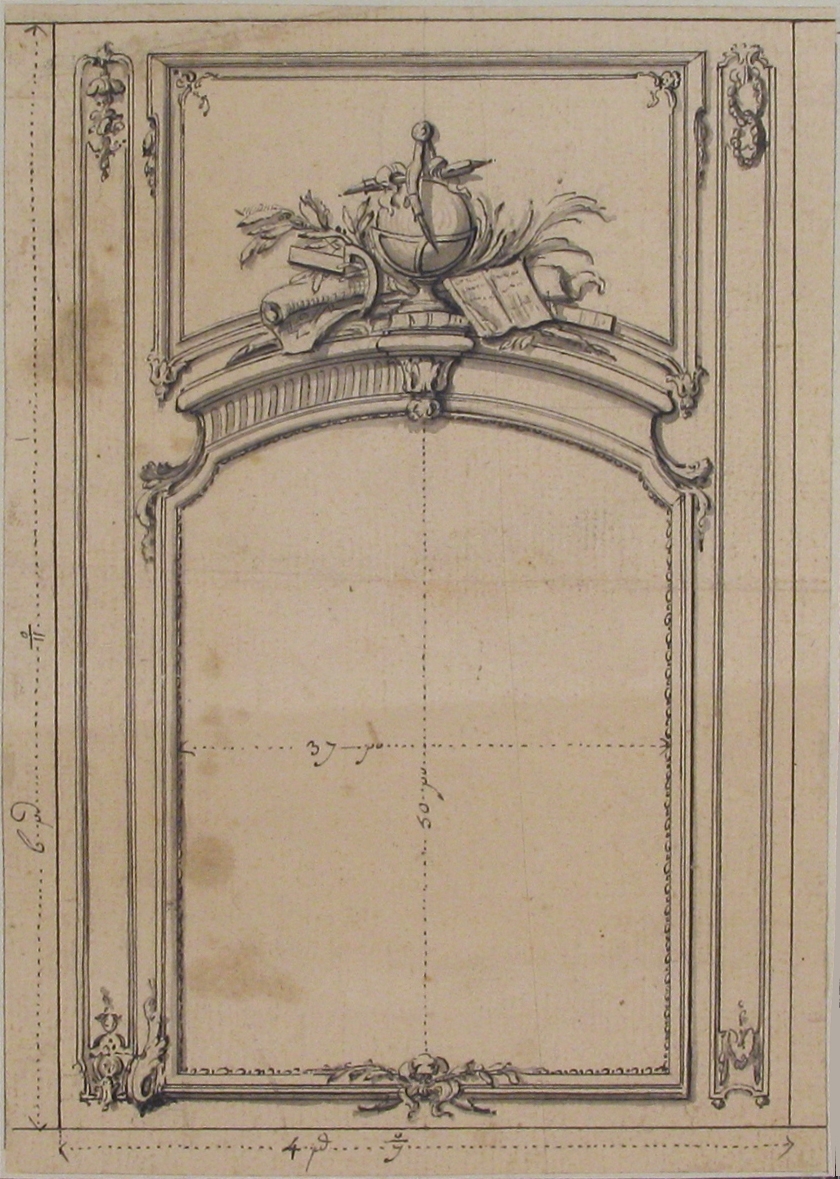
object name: drawing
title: Design for Wall Paneling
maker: anonymous, french, 18th century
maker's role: artist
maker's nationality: french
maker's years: 1700-1800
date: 1750-1770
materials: ink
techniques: brush, pen, wash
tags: architecture